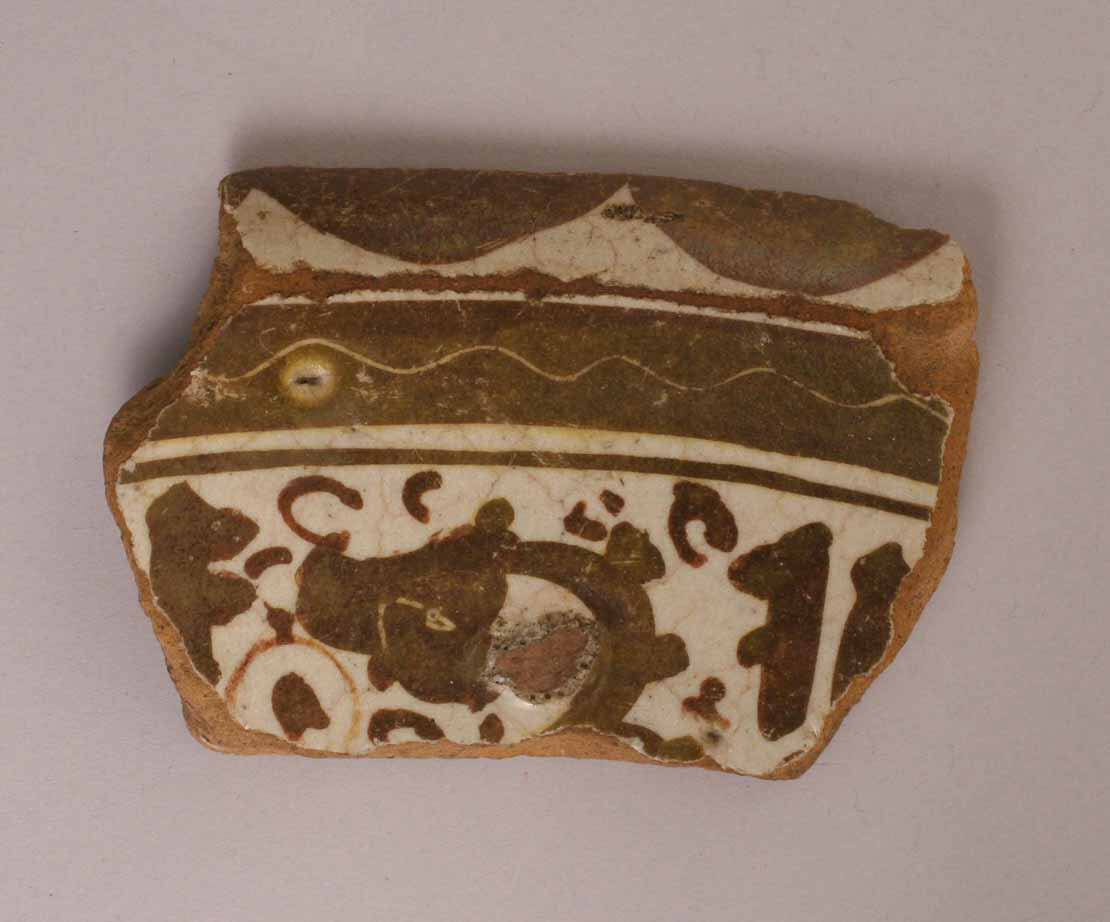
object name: ceramic fragment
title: Fragment of a Dish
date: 1001-1200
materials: earthenware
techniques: luster painting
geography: egypt